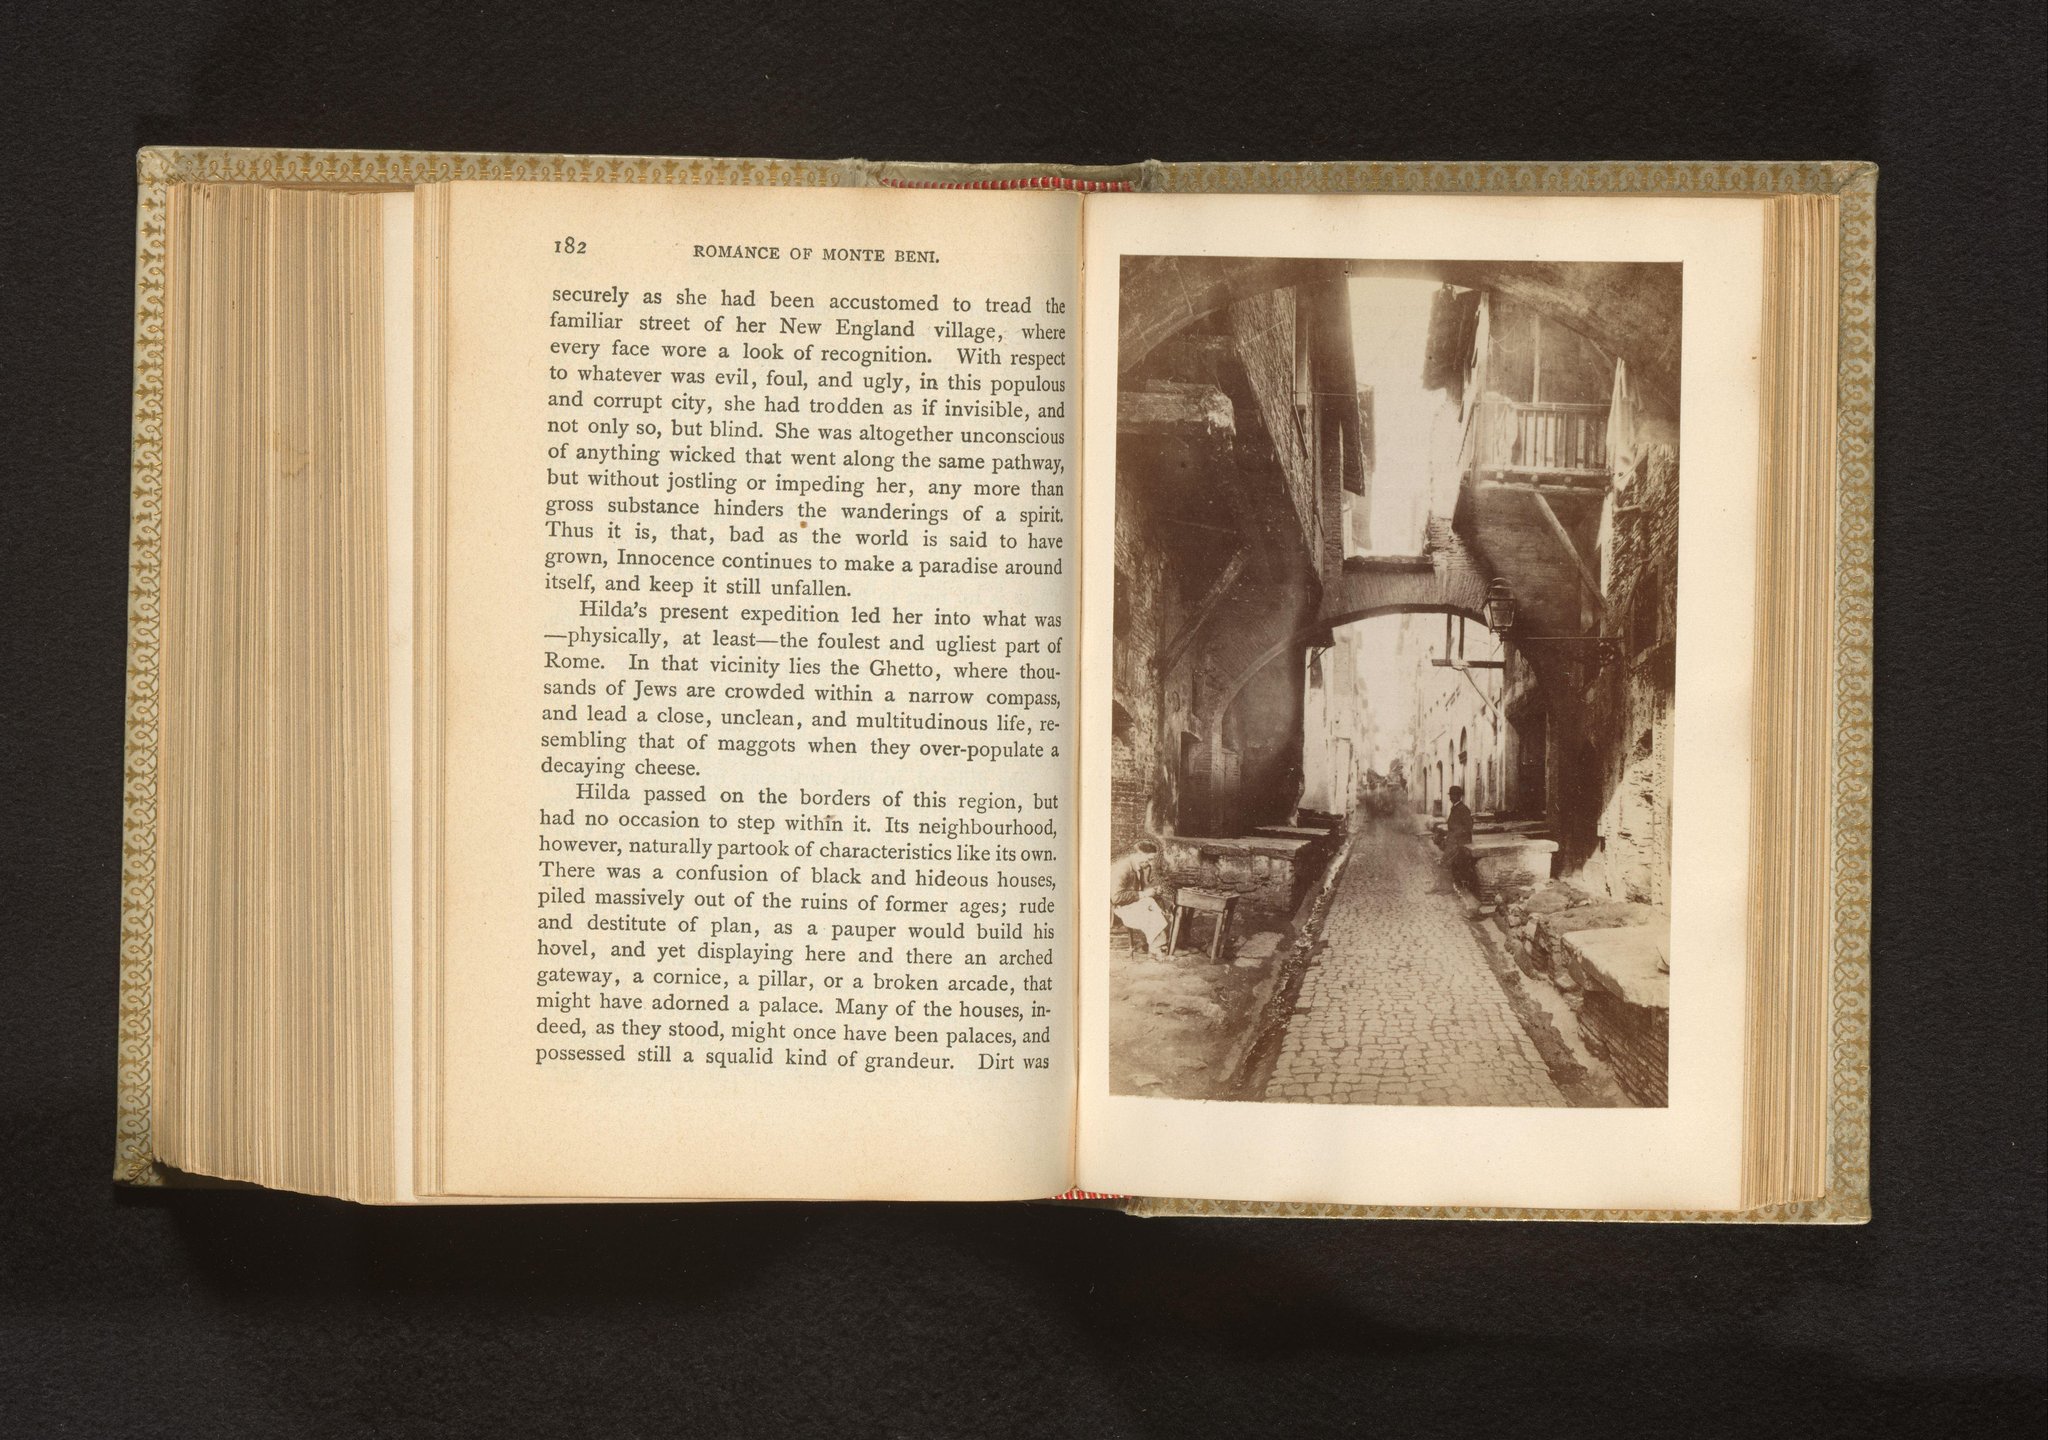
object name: photograph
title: Gezicht op een straat in de getto van Rome, met een man met een bolhoed en een man achter een tafel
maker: Anonymous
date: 1850-1860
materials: photographic support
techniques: albumen print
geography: rome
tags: head-gear: bowler hat, street, rome